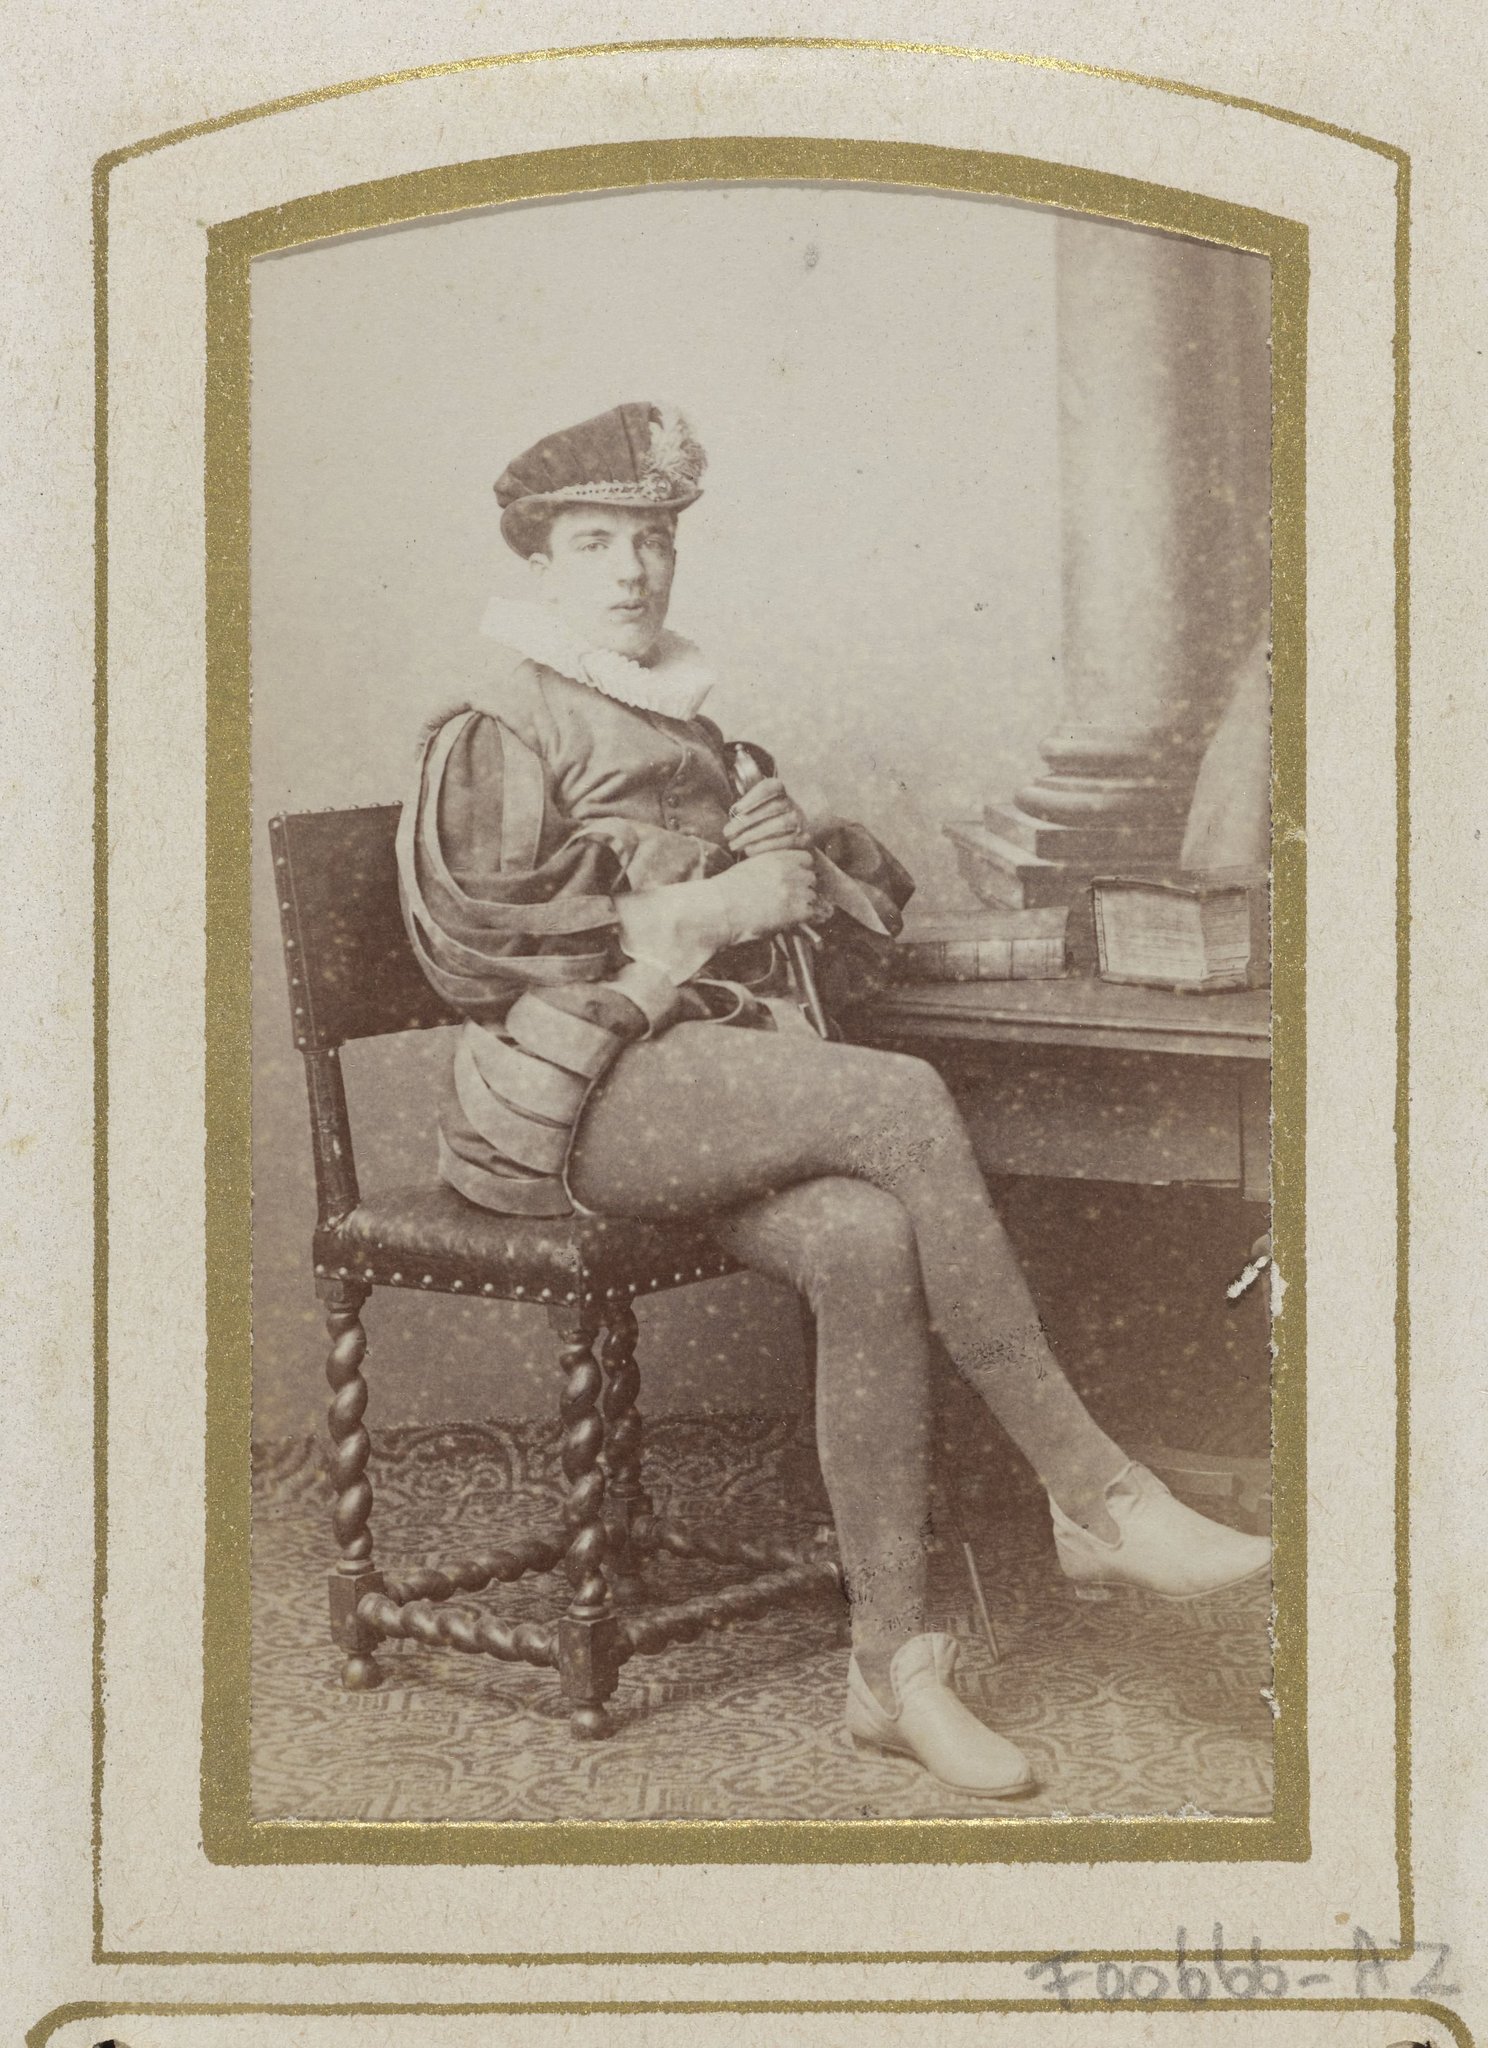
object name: photograph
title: Portret van een man in kostuum zittend aan een tafel met boeken, aangeduid als J. Wiarda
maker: jan goedeljee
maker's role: fotograaf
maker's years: 1824-1905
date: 1860-1905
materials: cardboard, photographic support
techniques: albumen print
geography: leiden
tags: historical persons, historical costume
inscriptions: name: ‘J. Wiarda/ 52.’, inscription: ‘J. Goedeljee/ Photograaf/ Z. K. H. PRINS ALEXANDER/ der Nederlanden/ PRINS van ORANJE/ en H. K. H./ PRINSES HENDRIK/ der Nederlanden/ Hoogewoerd 160/ nabij de Plantage.’